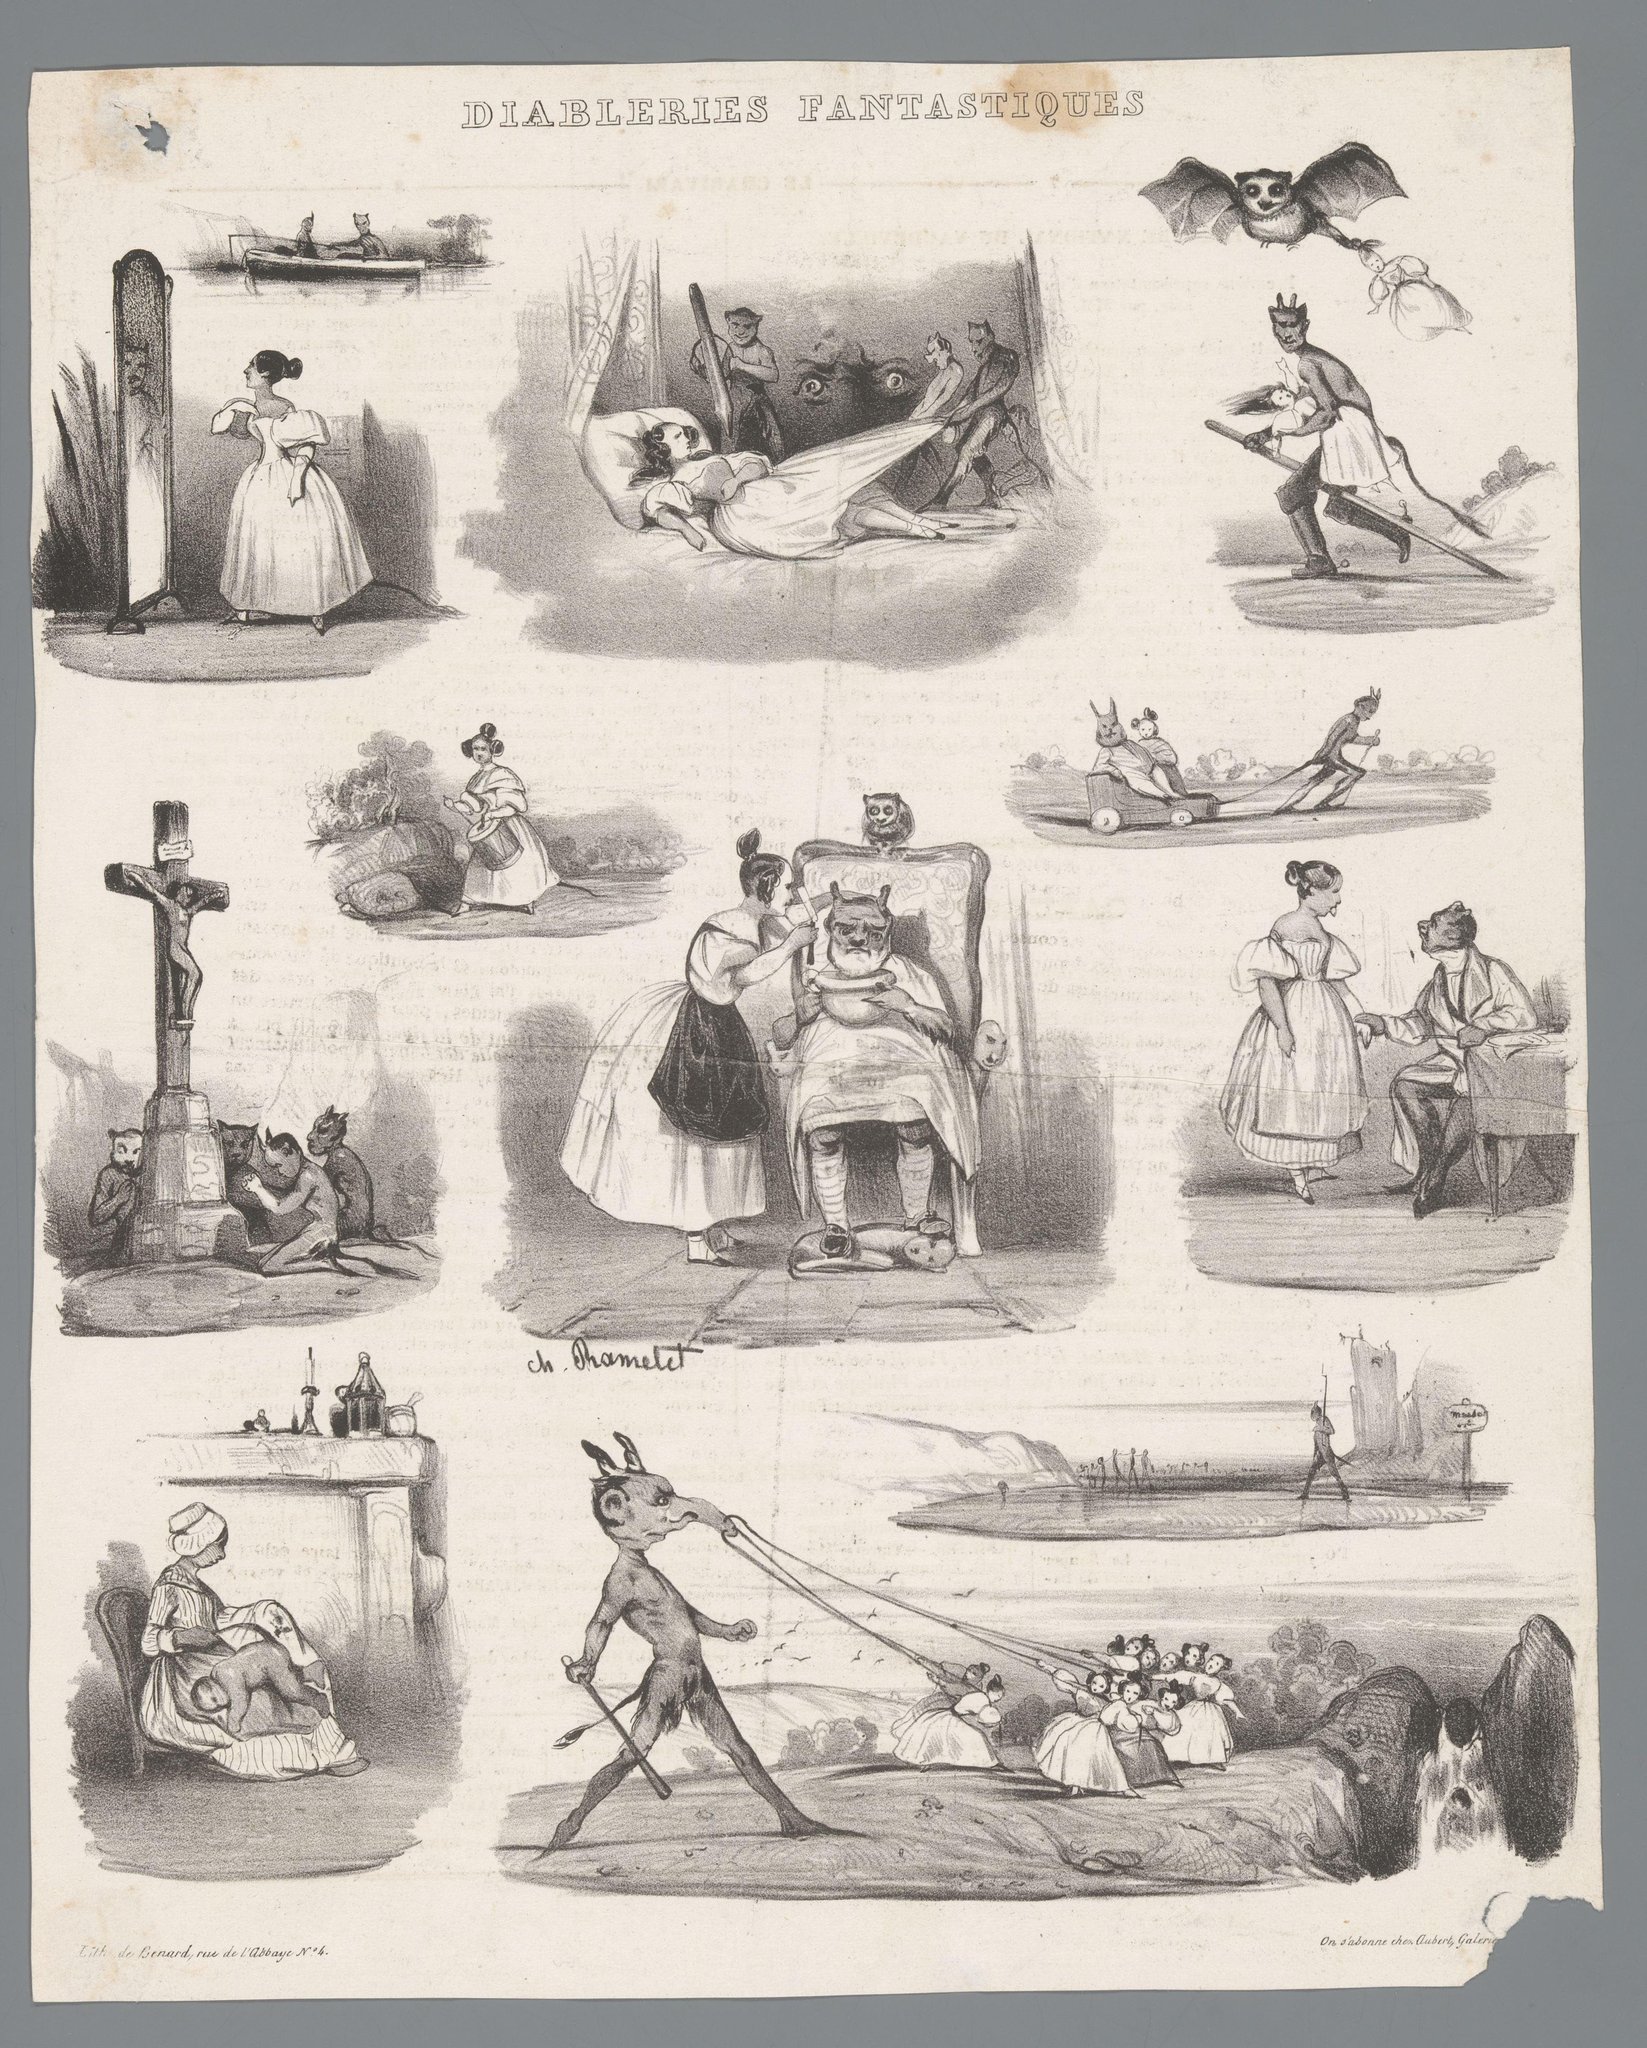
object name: print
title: Diableries fantastiques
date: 1833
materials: paper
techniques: letterpress printing, lithograph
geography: paris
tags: activities of devil(s)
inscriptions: collector's mark: Lugt 2228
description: Prent uit: Le Charivari 2 (1833), nr. 112, 22 maart 1833.